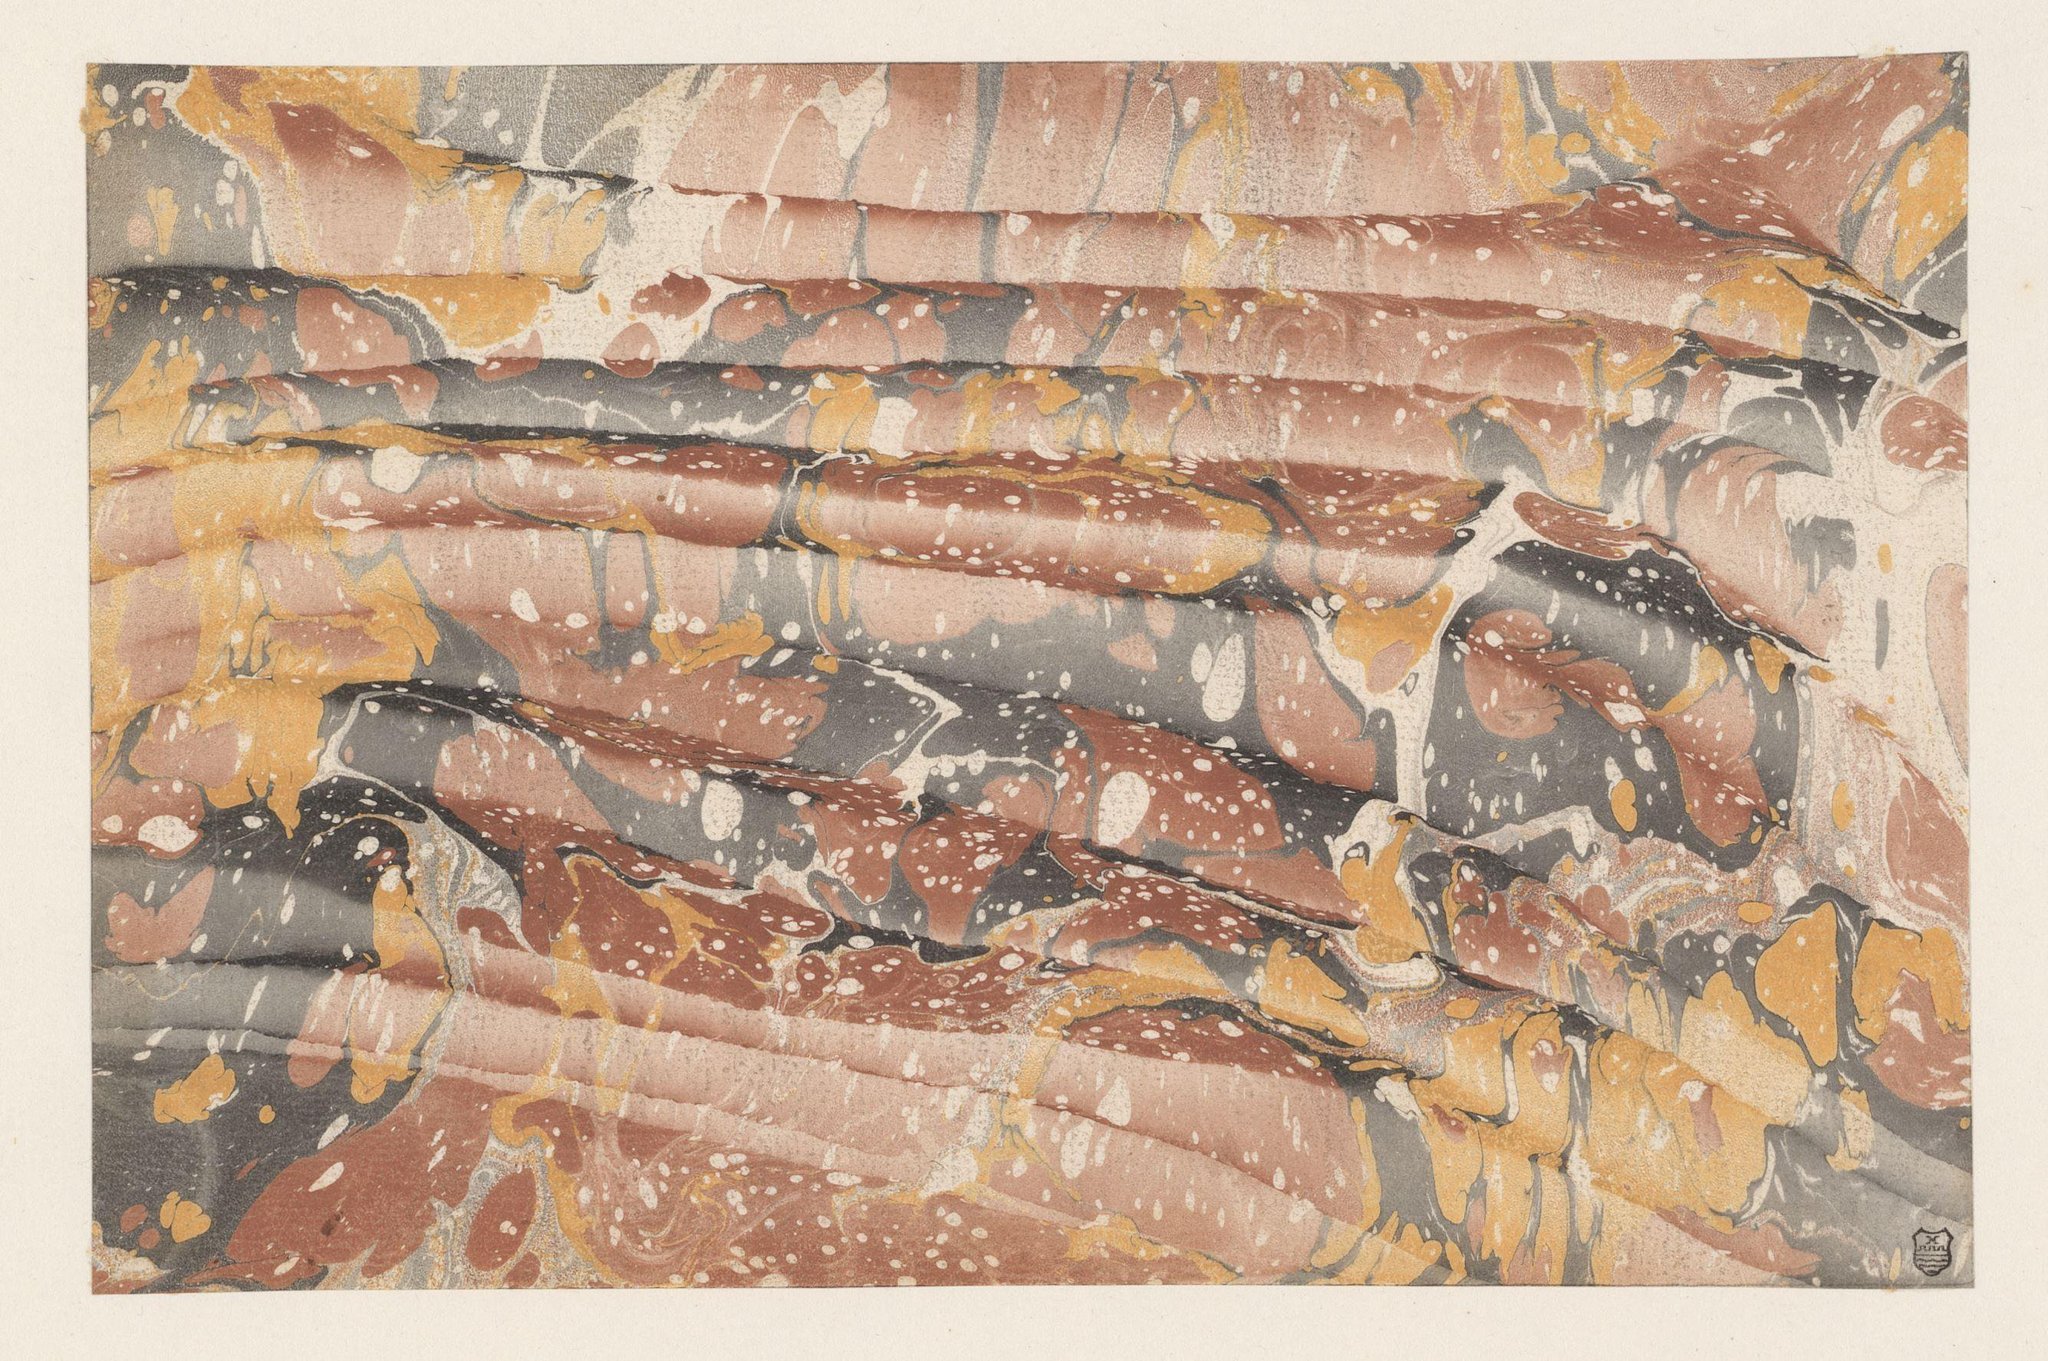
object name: marbled paper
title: Moirémarmer in bruin, grijs en geel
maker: Anonymous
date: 1700-1850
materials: paint, paper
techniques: marbling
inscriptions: collector's mark: Lugt 2760